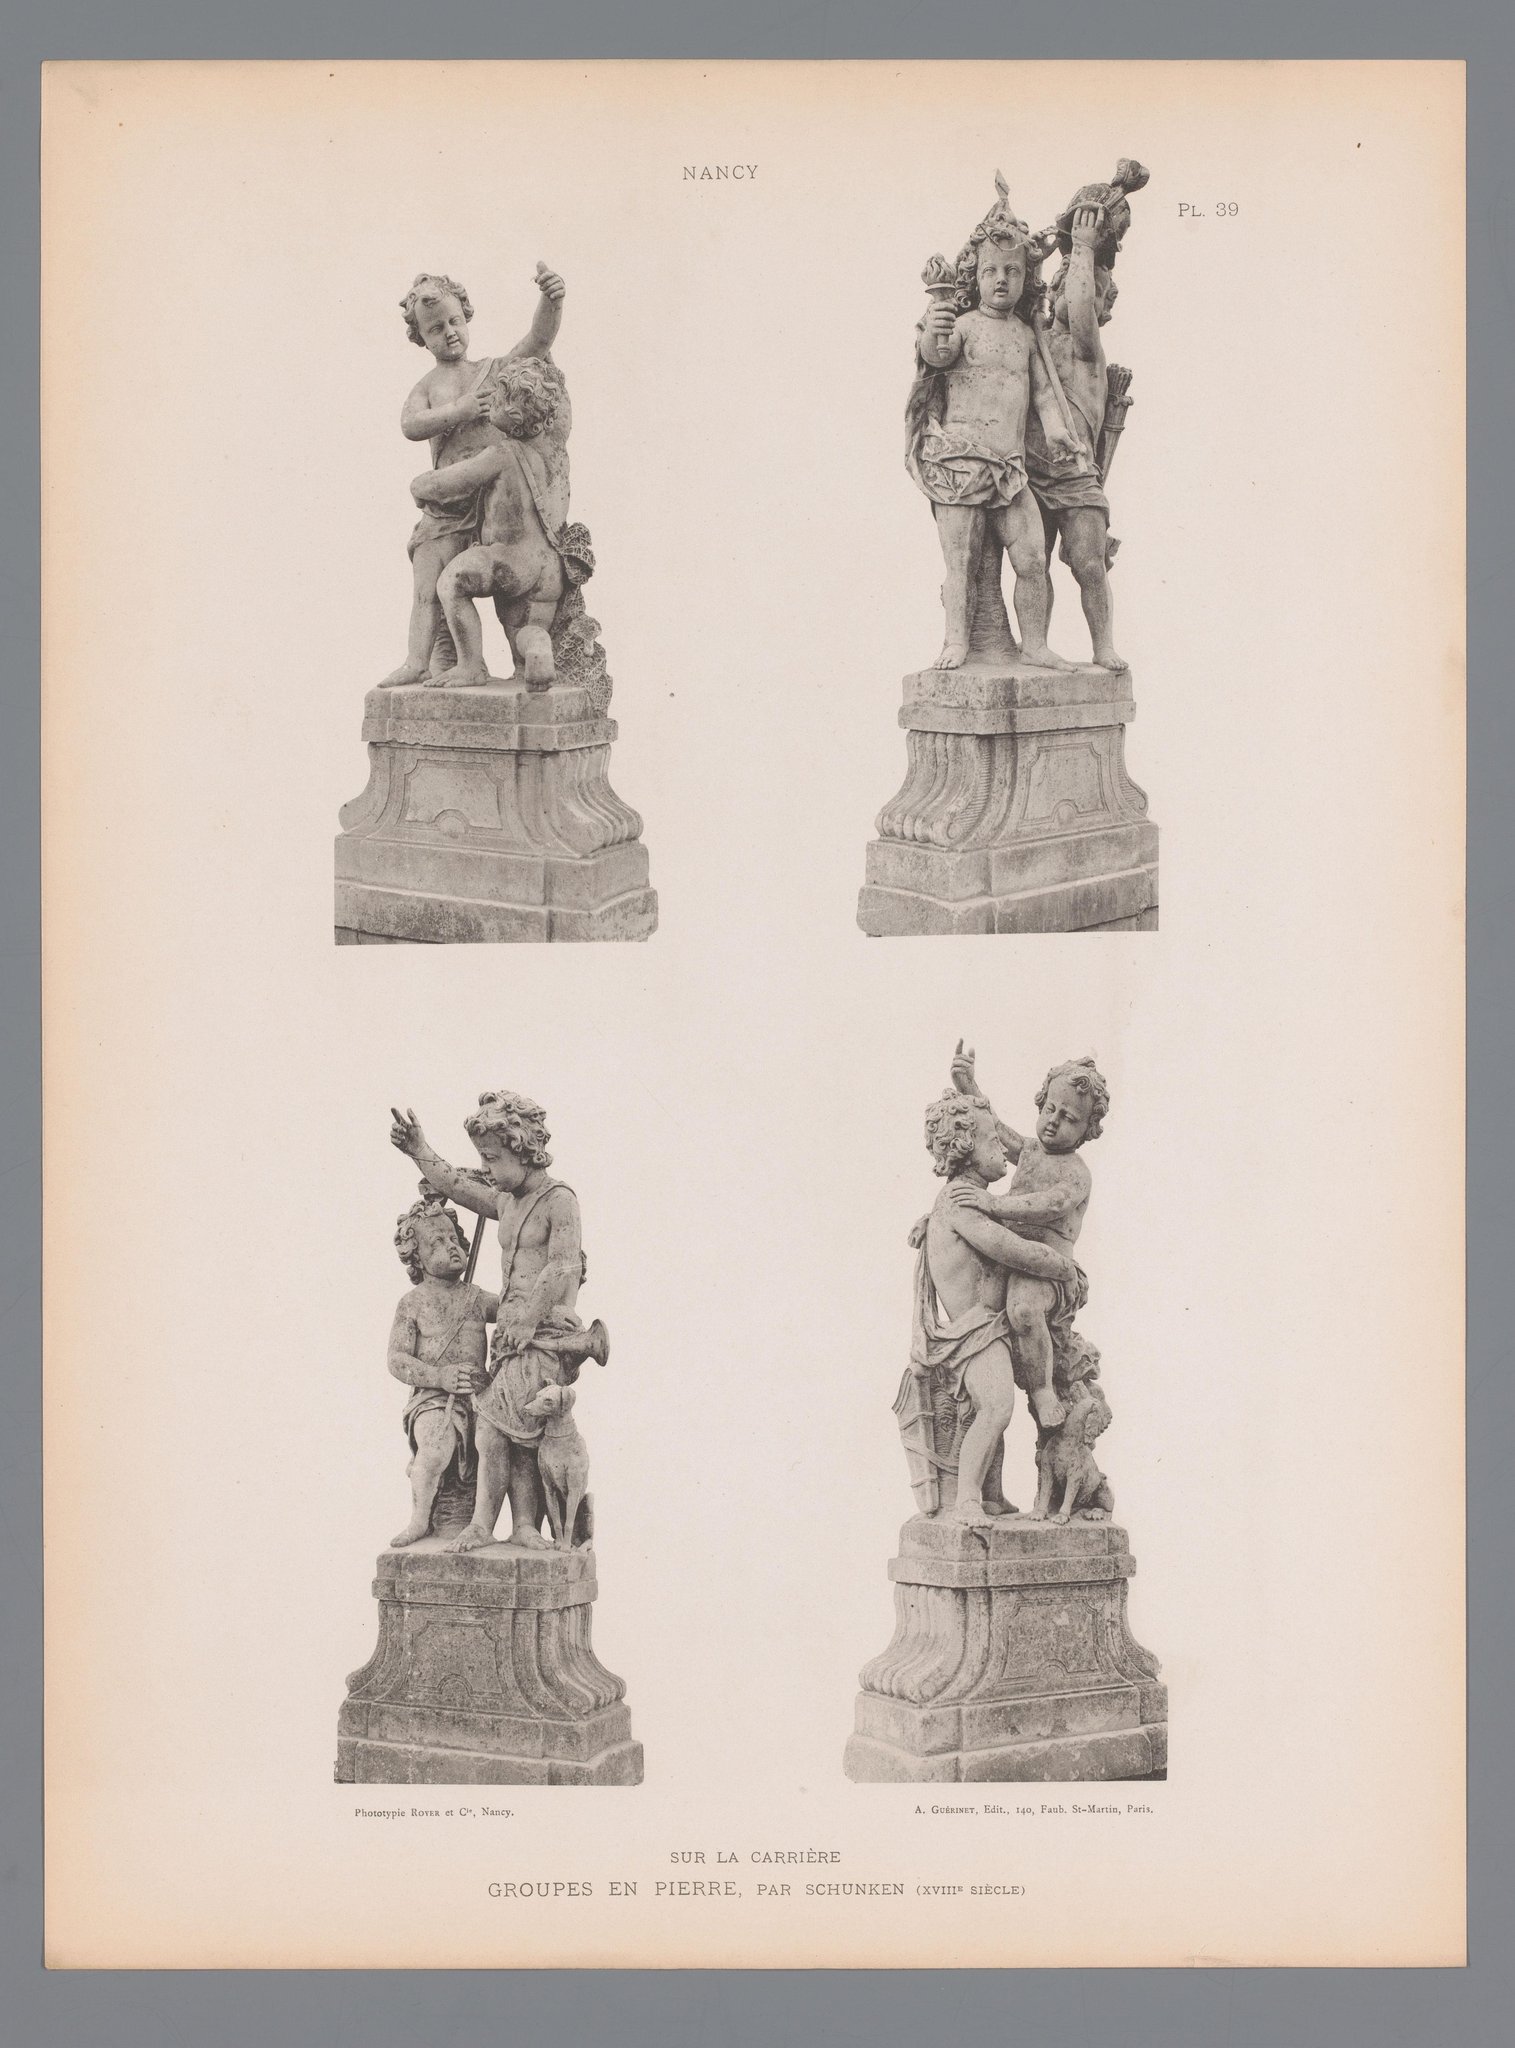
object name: photomechanical print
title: Vier opnames van standbeelden op Place de la Carrière te Nancy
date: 1891-1896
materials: paper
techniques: photograph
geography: paris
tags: square, place, circus, etc.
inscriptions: inscription: ‘Sur la Carrière/ Groupes en pierre, par Schunken (...)’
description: Deze prent maakt deel uit van een omslag met 103 prenten op 101 bladen en een titelblad.